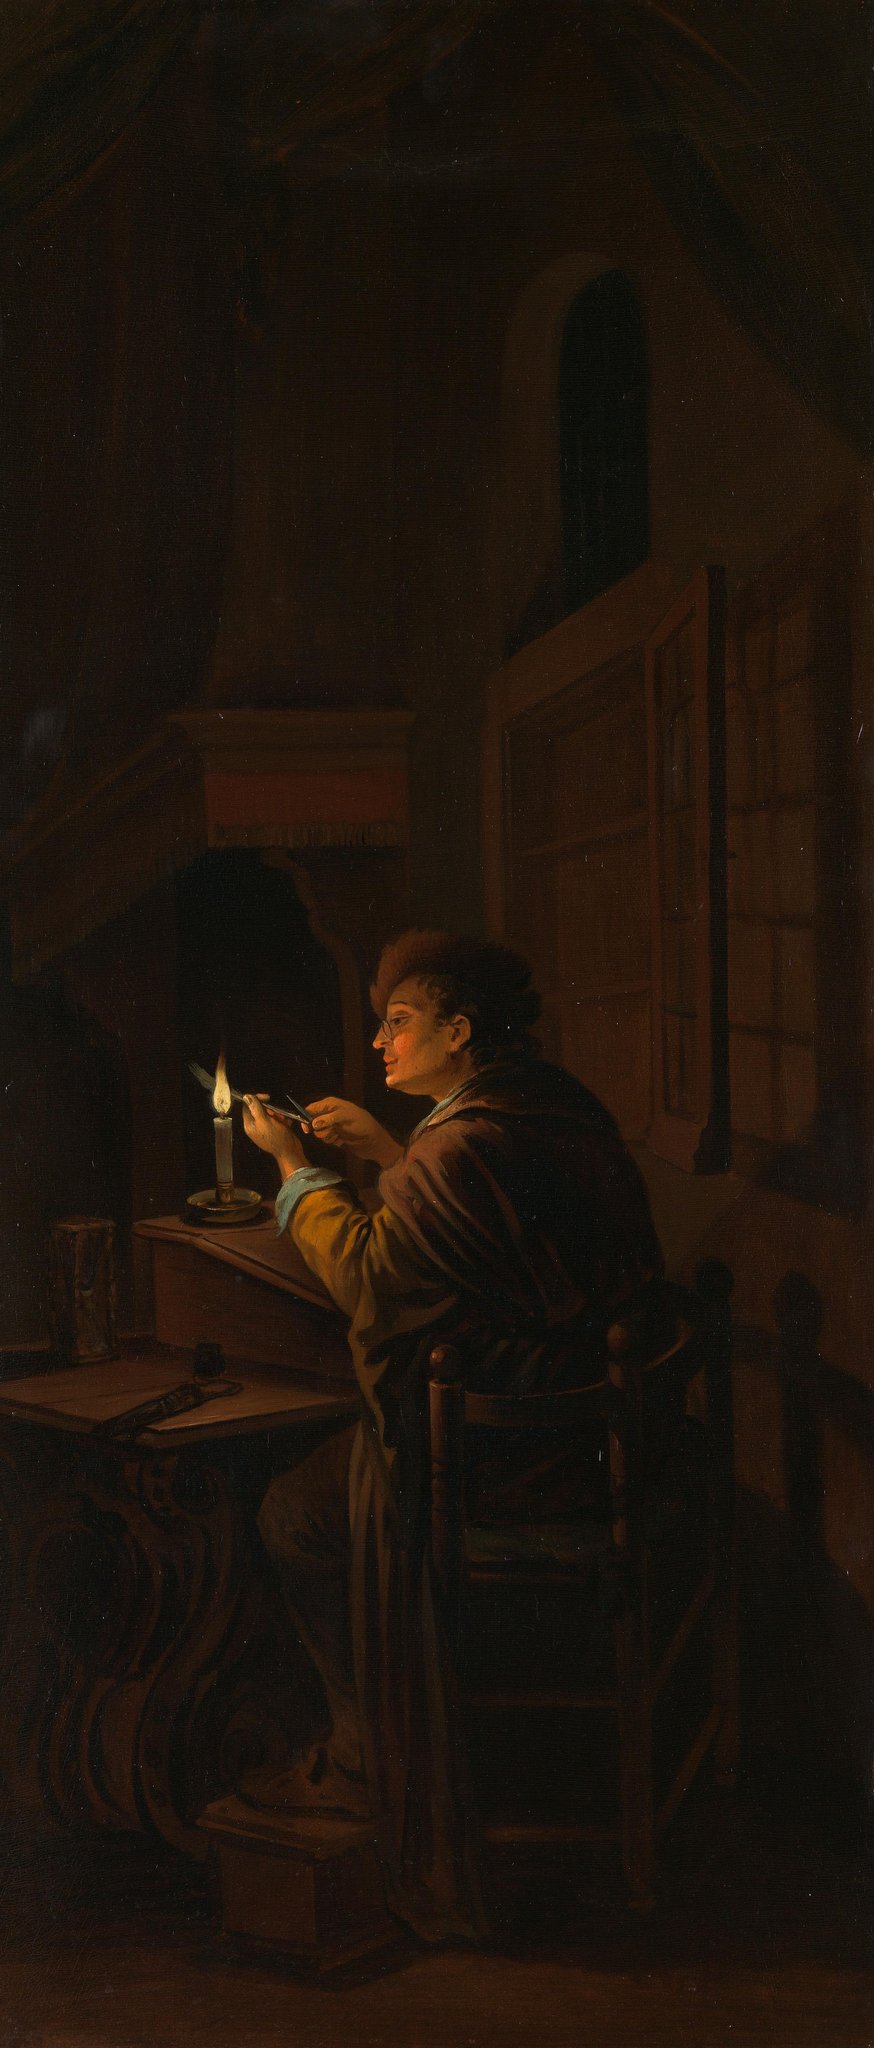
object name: zijpaneel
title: Triptych: Allegory of Art Training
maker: willem joseph laquy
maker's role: draughtsman, painter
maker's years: 1738-1798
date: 1770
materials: oil, paint, panel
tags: candle, symbolic representations, allegories and emblems ~ art; 'arte' (ripa), sharpening pen (quill), studying at night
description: Drieluik met een allegorie op het kunstonderwijs. Op het middenpaneel een kraamkamer; een vrouw geeft een kind de borst. Zij is gezeten aan een tafel, de wieg en een mand voor haar op de vloer. Van het plafond hangt een kroonluchter, aan de muur de opgezette kop van een hert. Op de achtergrond een tandarts. De kraamkamer symboliseert de natuur. Het linker zijpaneel toont een avondschool waar bij het licht van kaarsen en een lantaarn schrijven wordt geleerd. De school symboliseert het onderwijs. Op het rechter zijpaneel snijdt een geleerde in zijn werkkamer een pen bij het licht van de kaars. De pennensnijder symboliseert oefening. (voor het middenstuk en linker zijpaneel zie SK-A-2320-A/B)